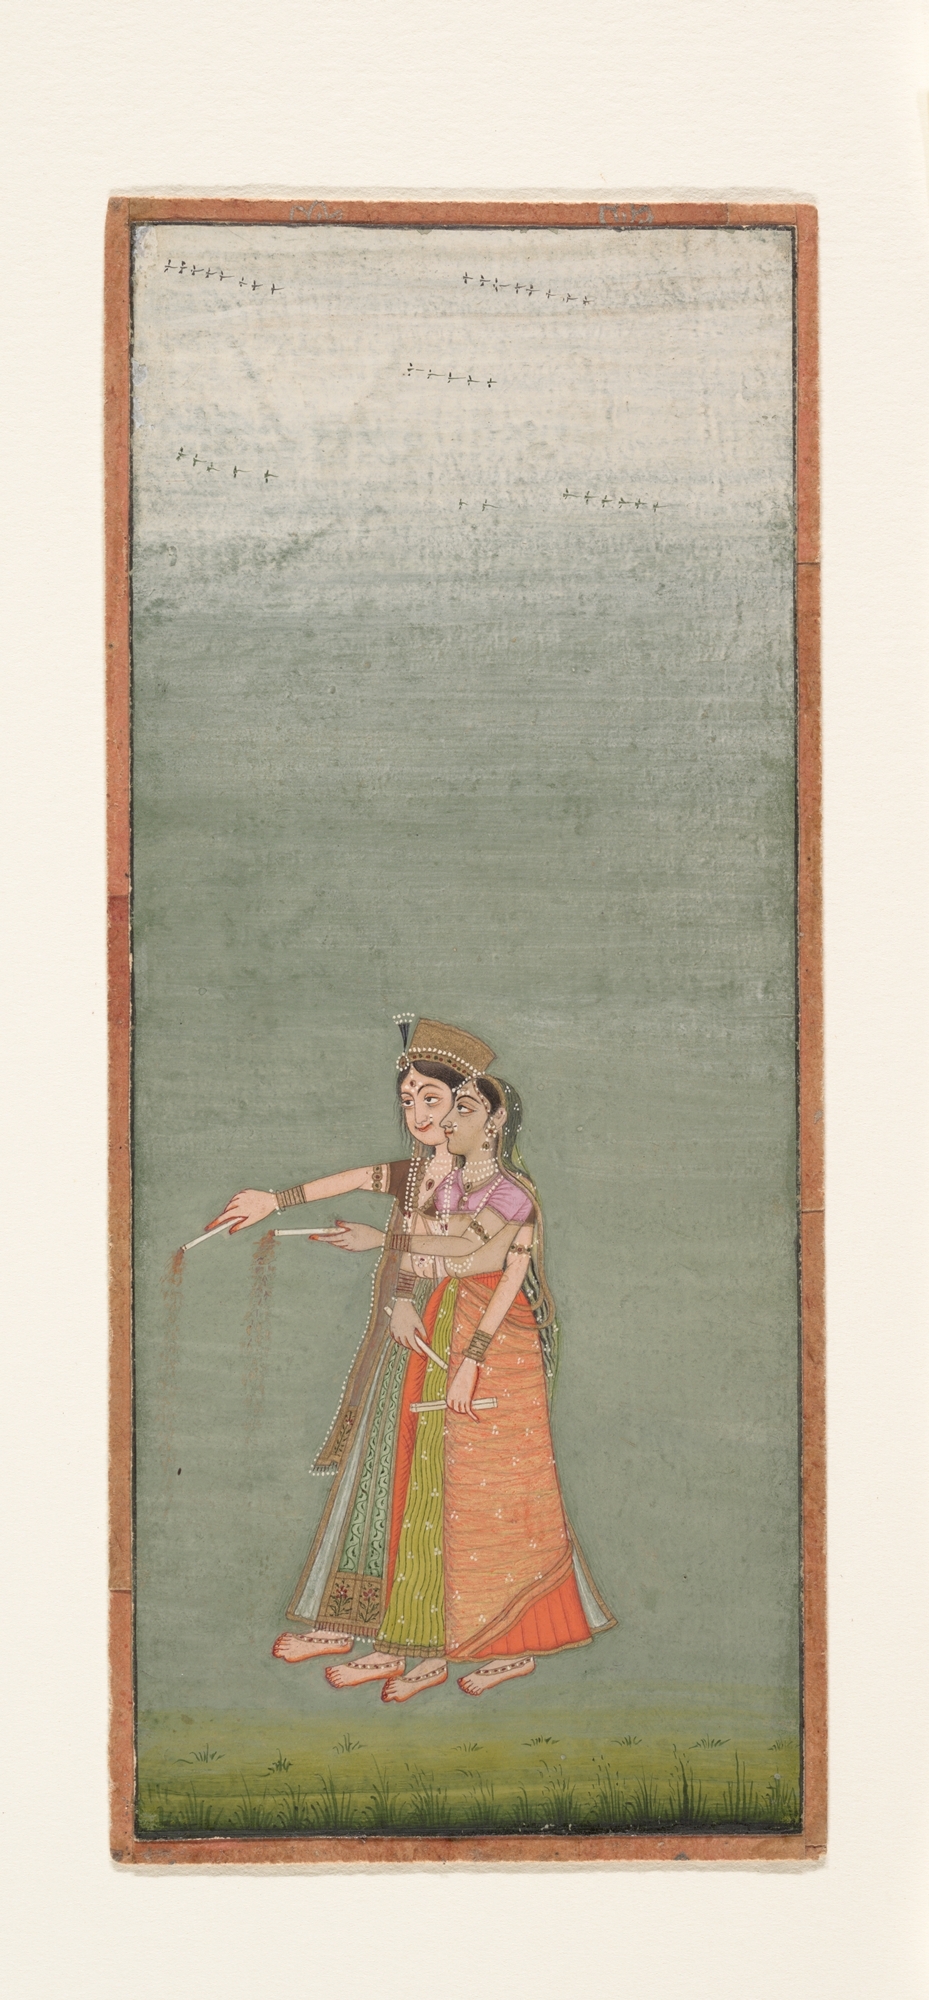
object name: painting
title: Two Court Ladies with Fireworks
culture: indian, rajasthani, bikaner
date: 1725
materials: ink, paper, watercolor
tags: women,fireworks